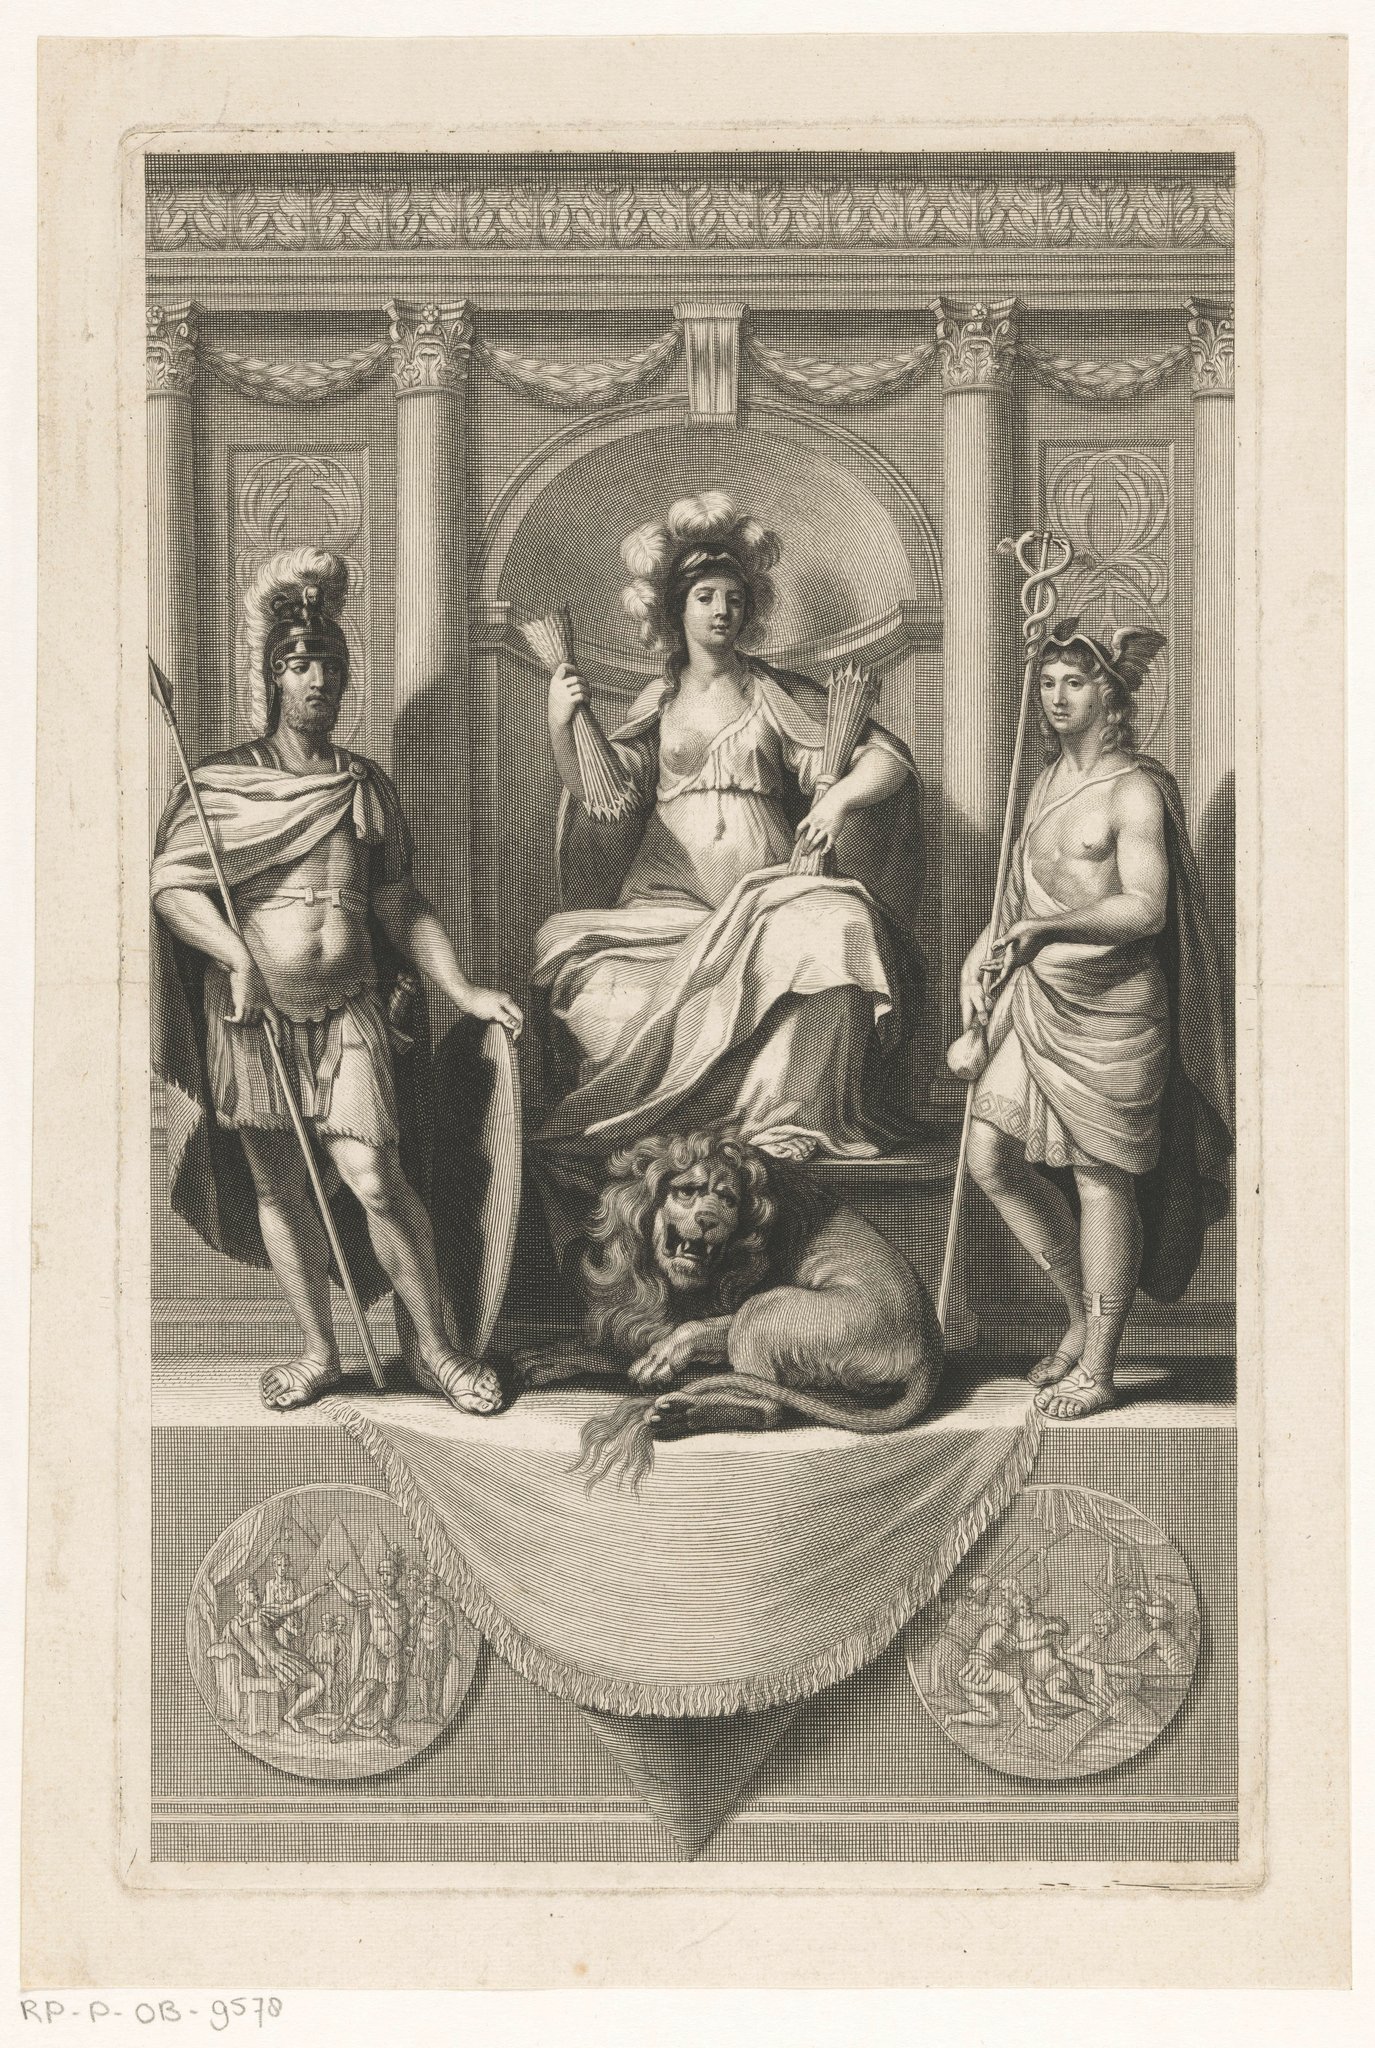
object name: print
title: Hollandse maagd geflankeerd door Mars en Mercurius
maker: jan van munnickhuysen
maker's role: draughtsman, print maker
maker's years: 1655-1701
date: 1677-1730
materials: paper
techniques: engraving, etching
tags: (story of) mars (ares), personifications of countries, nations, states, districts, etc., (story of) mercury (hermes)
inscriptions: collector's mark: Lugt 2760, collector's mark: Lugt 2228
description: Hollandse maagd met pijlenbundels op haar troon, aan weerszijden Mars en Mercurius. Bij haar voeten ligt de Nederlandse leeuw.